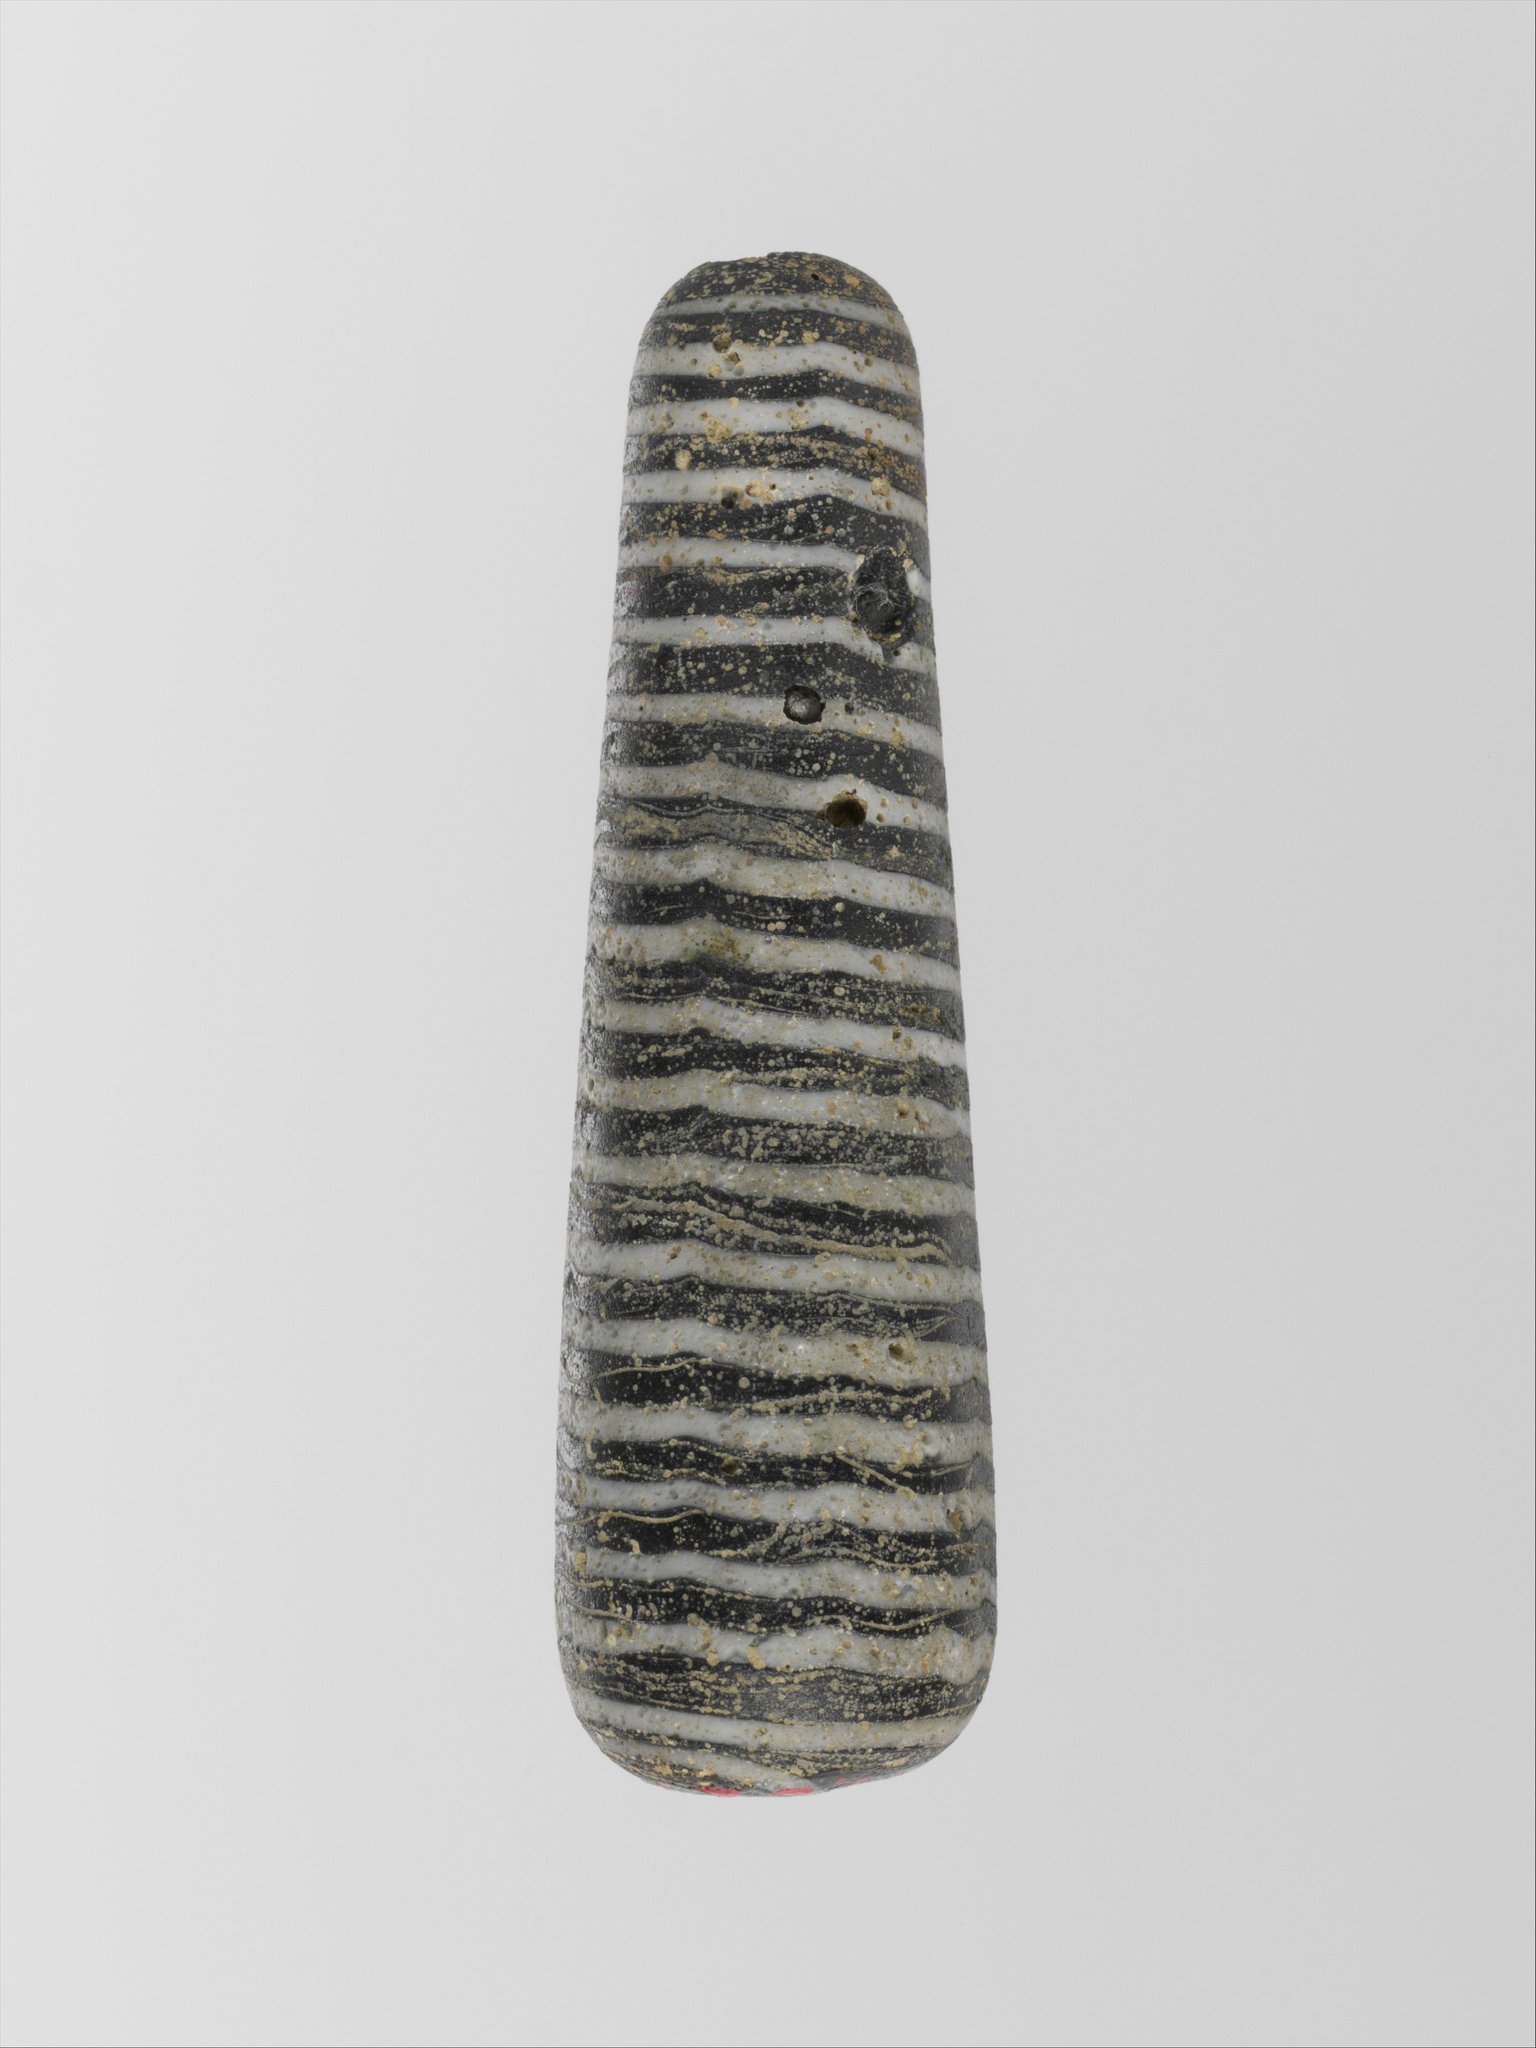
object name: plumbline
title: Glass pendant bead in the shape of a plumbline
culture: etruscan or greek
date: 700-401 BCE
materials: glass